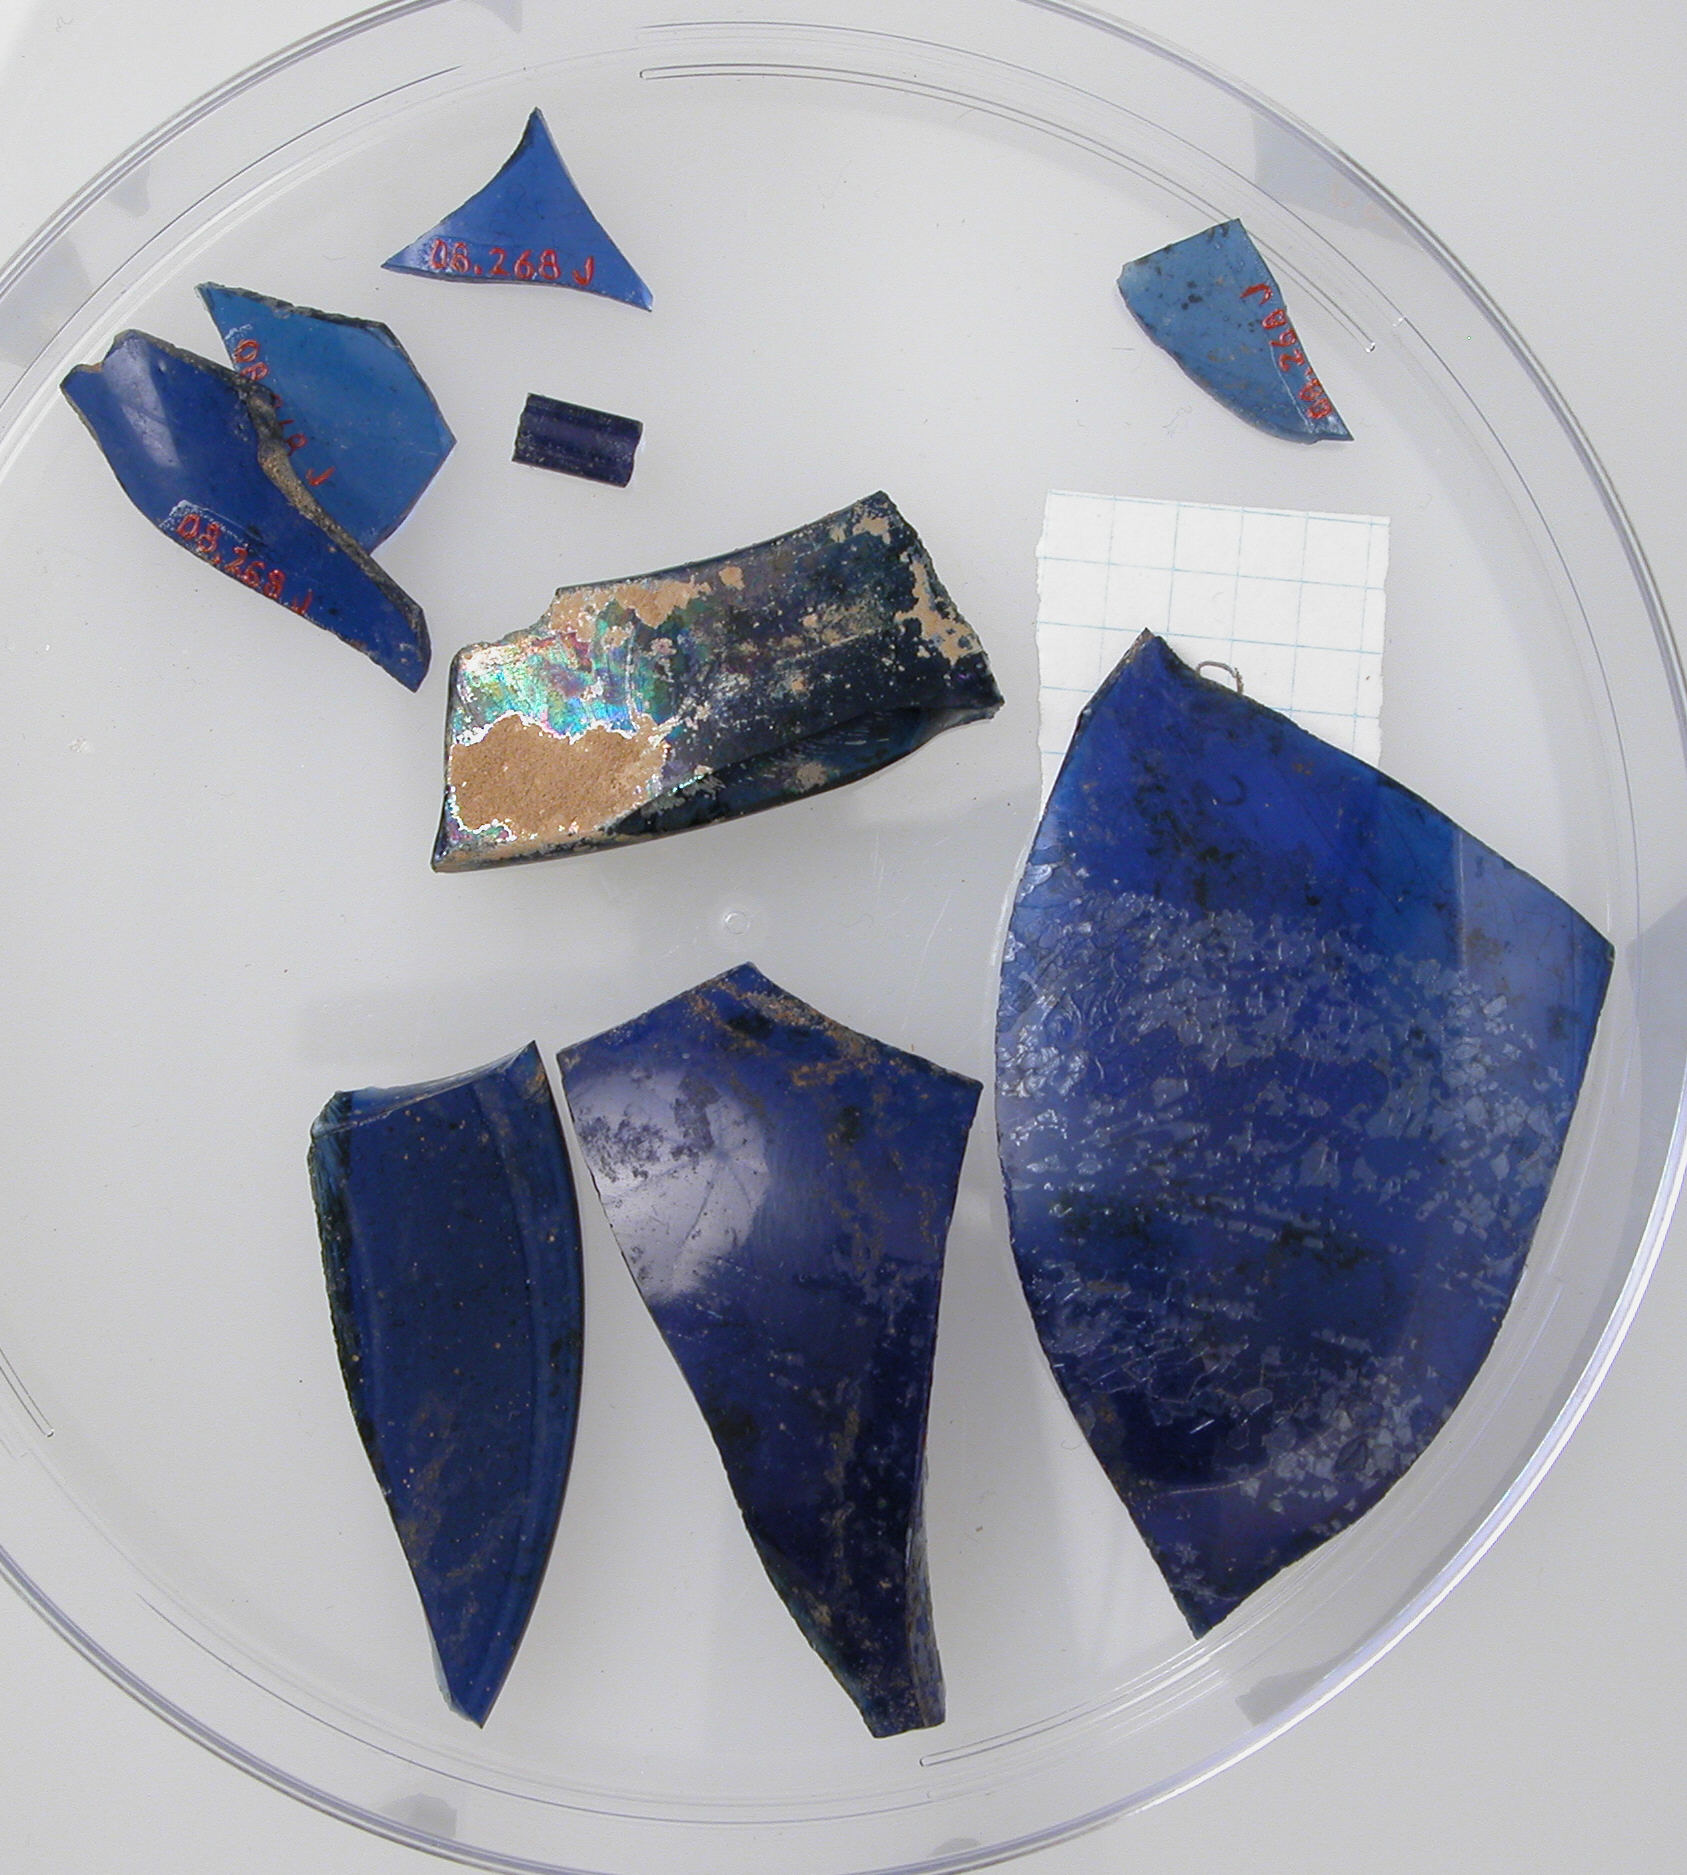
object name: fragment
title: Glass Fragments from a Vessel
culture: coptic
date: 301-433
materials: glass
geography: egypt